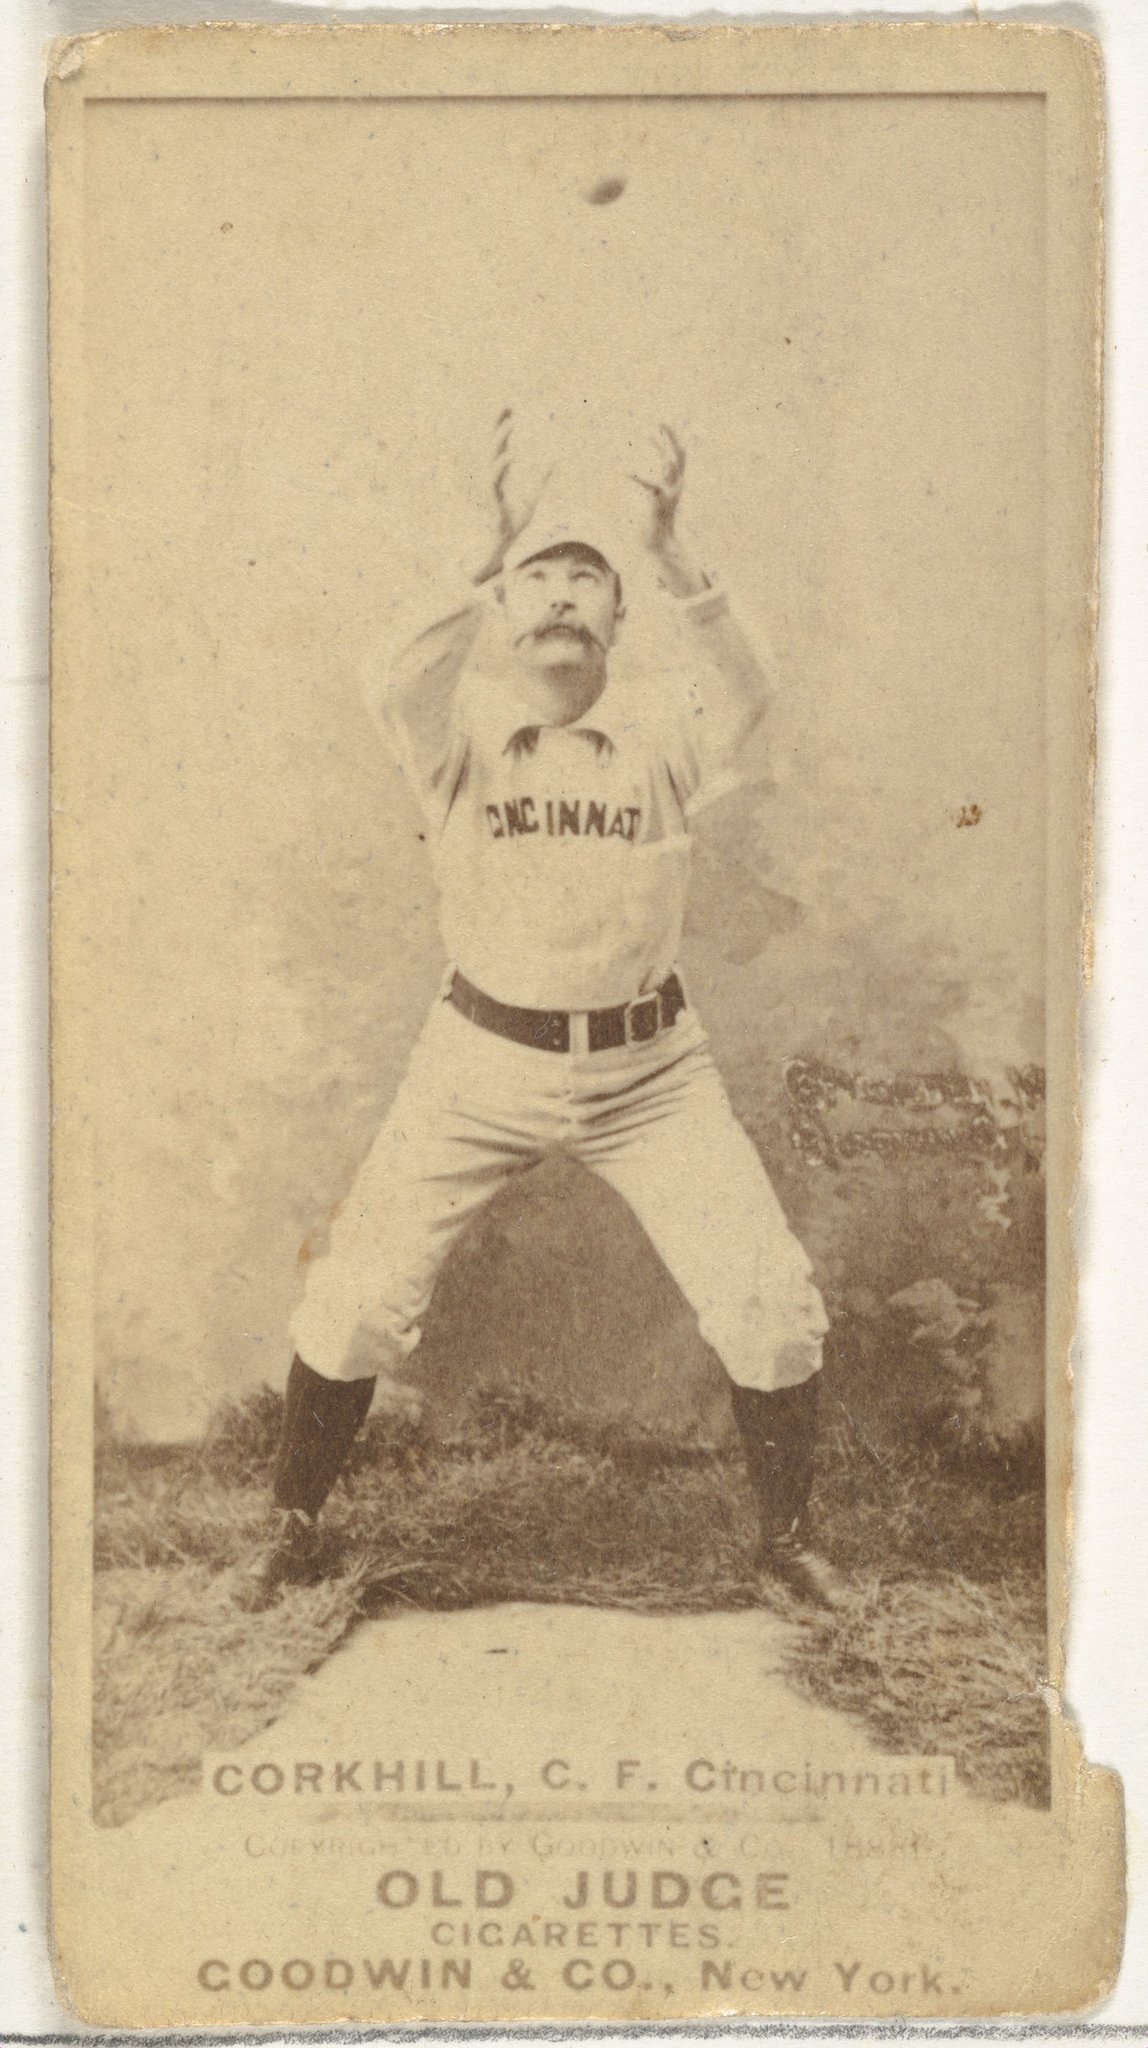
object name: baseball card, photograph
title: John Stewart "Pop" Corkhill, Center Field, Cincinnati, from the Old Judge series (N172) for Old Judge Cigarettes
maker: goodwin & company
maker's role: publisher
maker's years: 1850-1950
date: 1887-1890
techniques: albumen silver print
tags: men,portraits,baseball,athletes